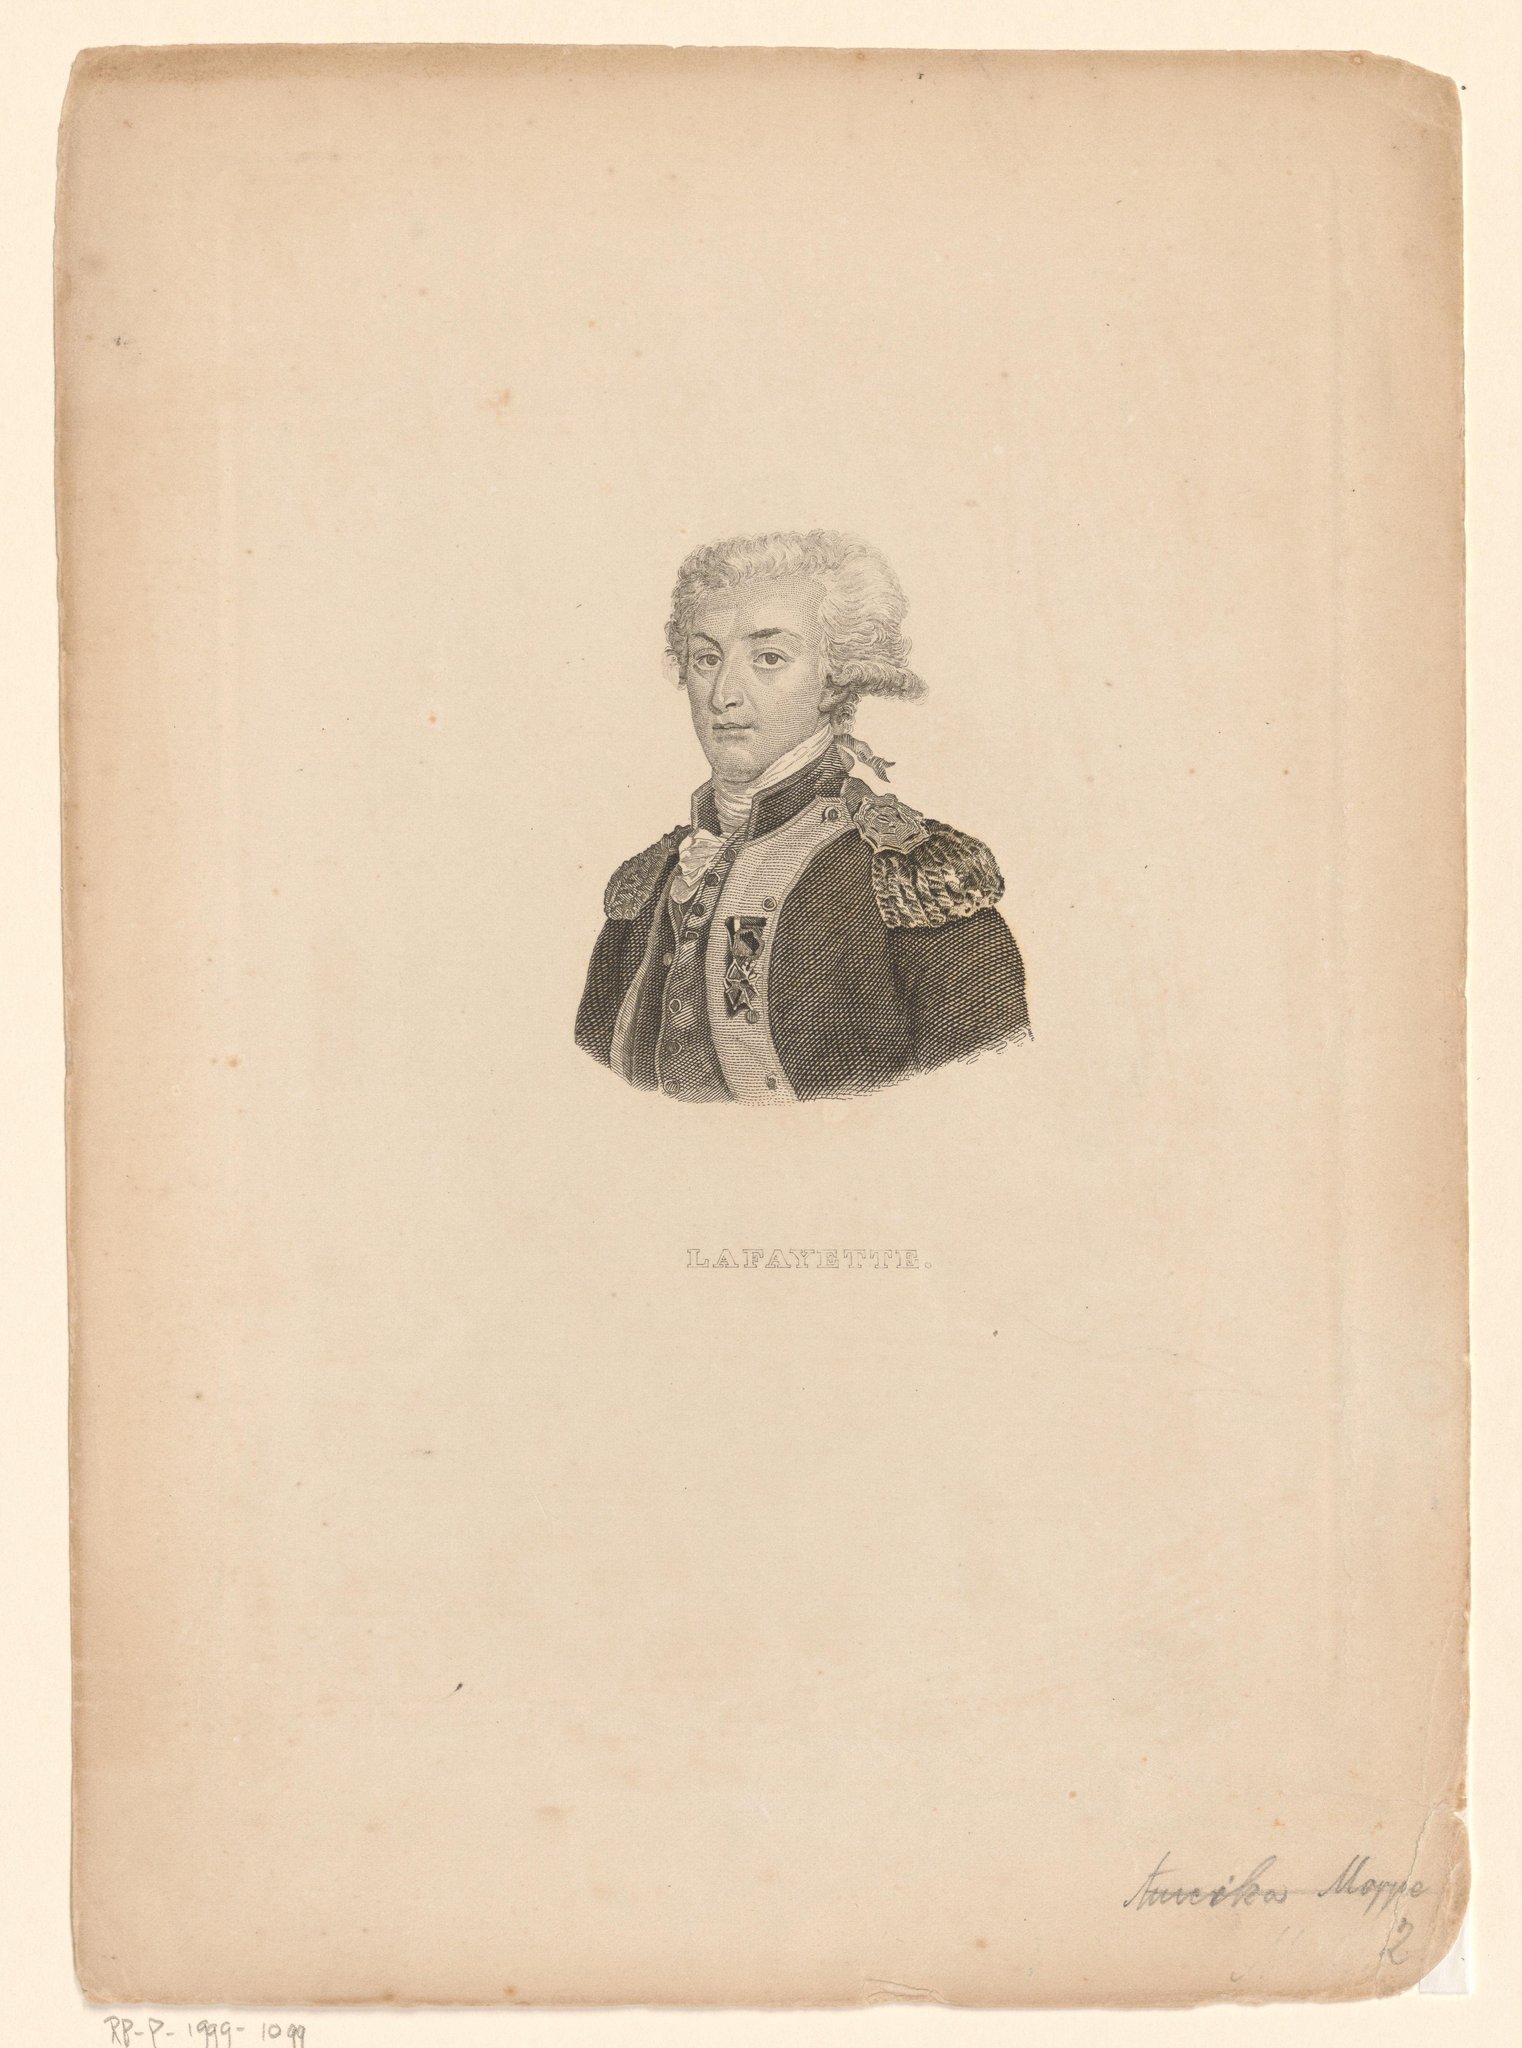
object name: print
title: Portret Gilbert du Motier de La Fayette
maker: Anonymous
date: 1800-1850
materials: paper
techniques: etching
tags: politician, historical persons, wig, (military) uniforms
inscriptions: collector's mark: Lugt 2228, collector's mark: Lugt 2760